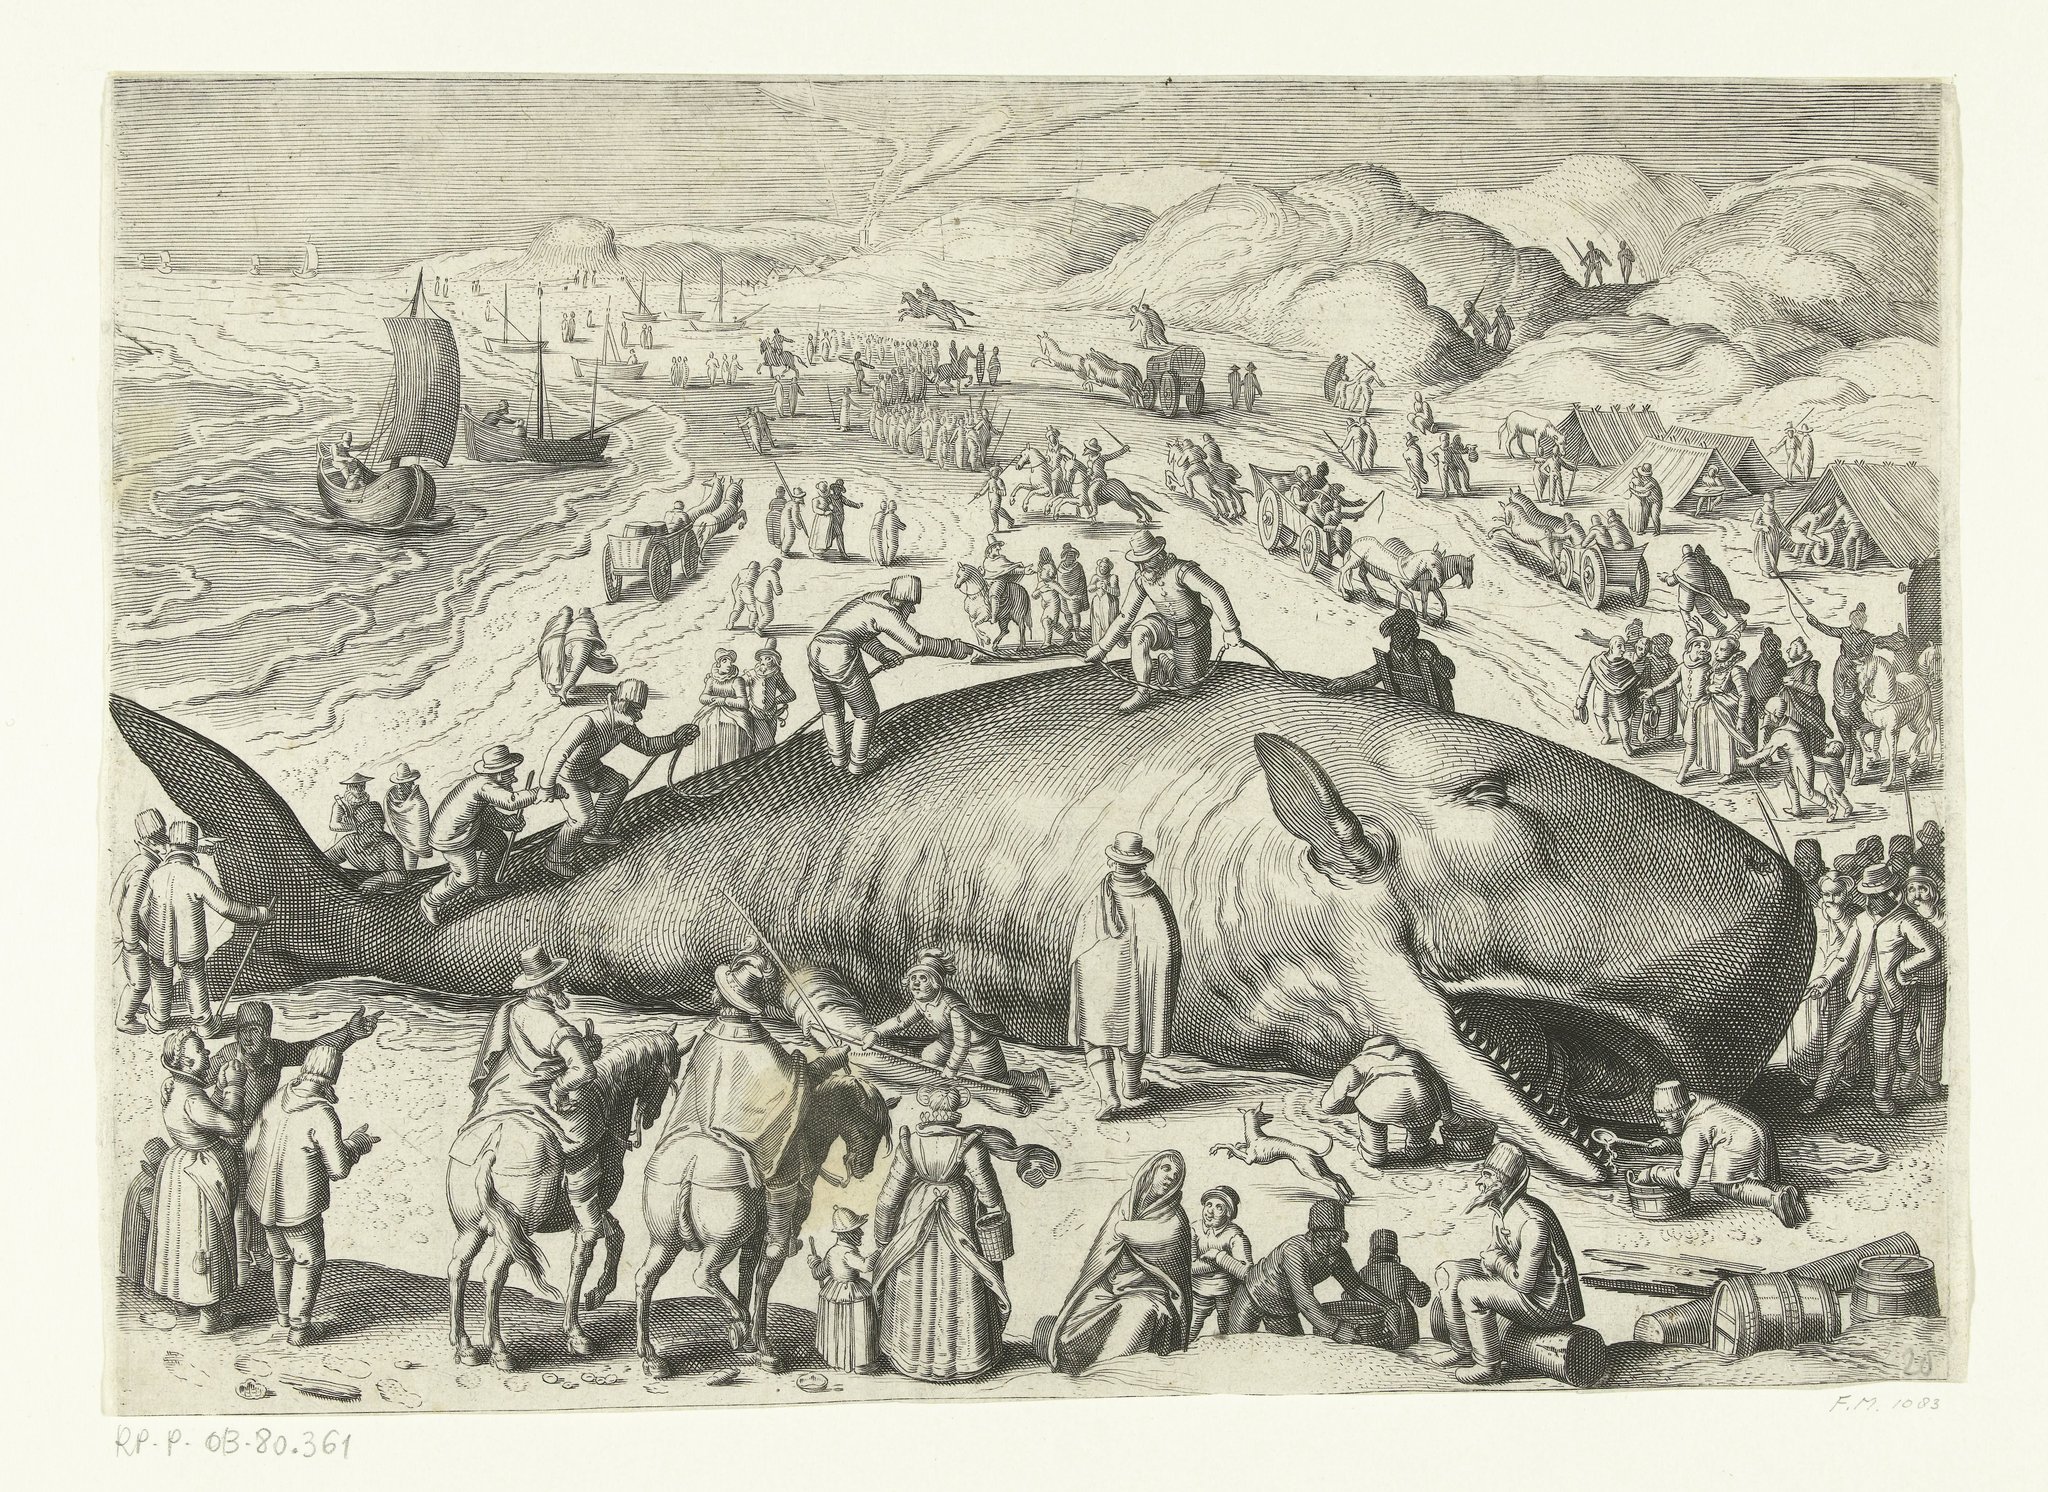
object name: history print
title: Kopie van de gestrande walvis bij Berckhey van 1598 als de walvis gestand bij Noordwijk in 1614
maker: Anonymous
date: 1614-1615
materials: paper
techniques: engraving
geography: northern netherlands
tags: swimming mammals: whale (+ dying animal; death of animal; dead animal)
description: Vrije kopie naar de prent van de walvis (potvis) gestrand op 2 februari 1598 op het strand bij Berckhey tussen Katwijk en Scheveningen, hier voorgesteld als de walvis gestrand bij Noordwijk op 28 december 1614. Vijf mannen beklimmen het dier om het op te meten. Met veel bezoekers, op de voorgrond enkele ruiters, achter het dier mensen, tenten en wagens op het strand. Vrije kopie naar het origineel van Jacob Matham.